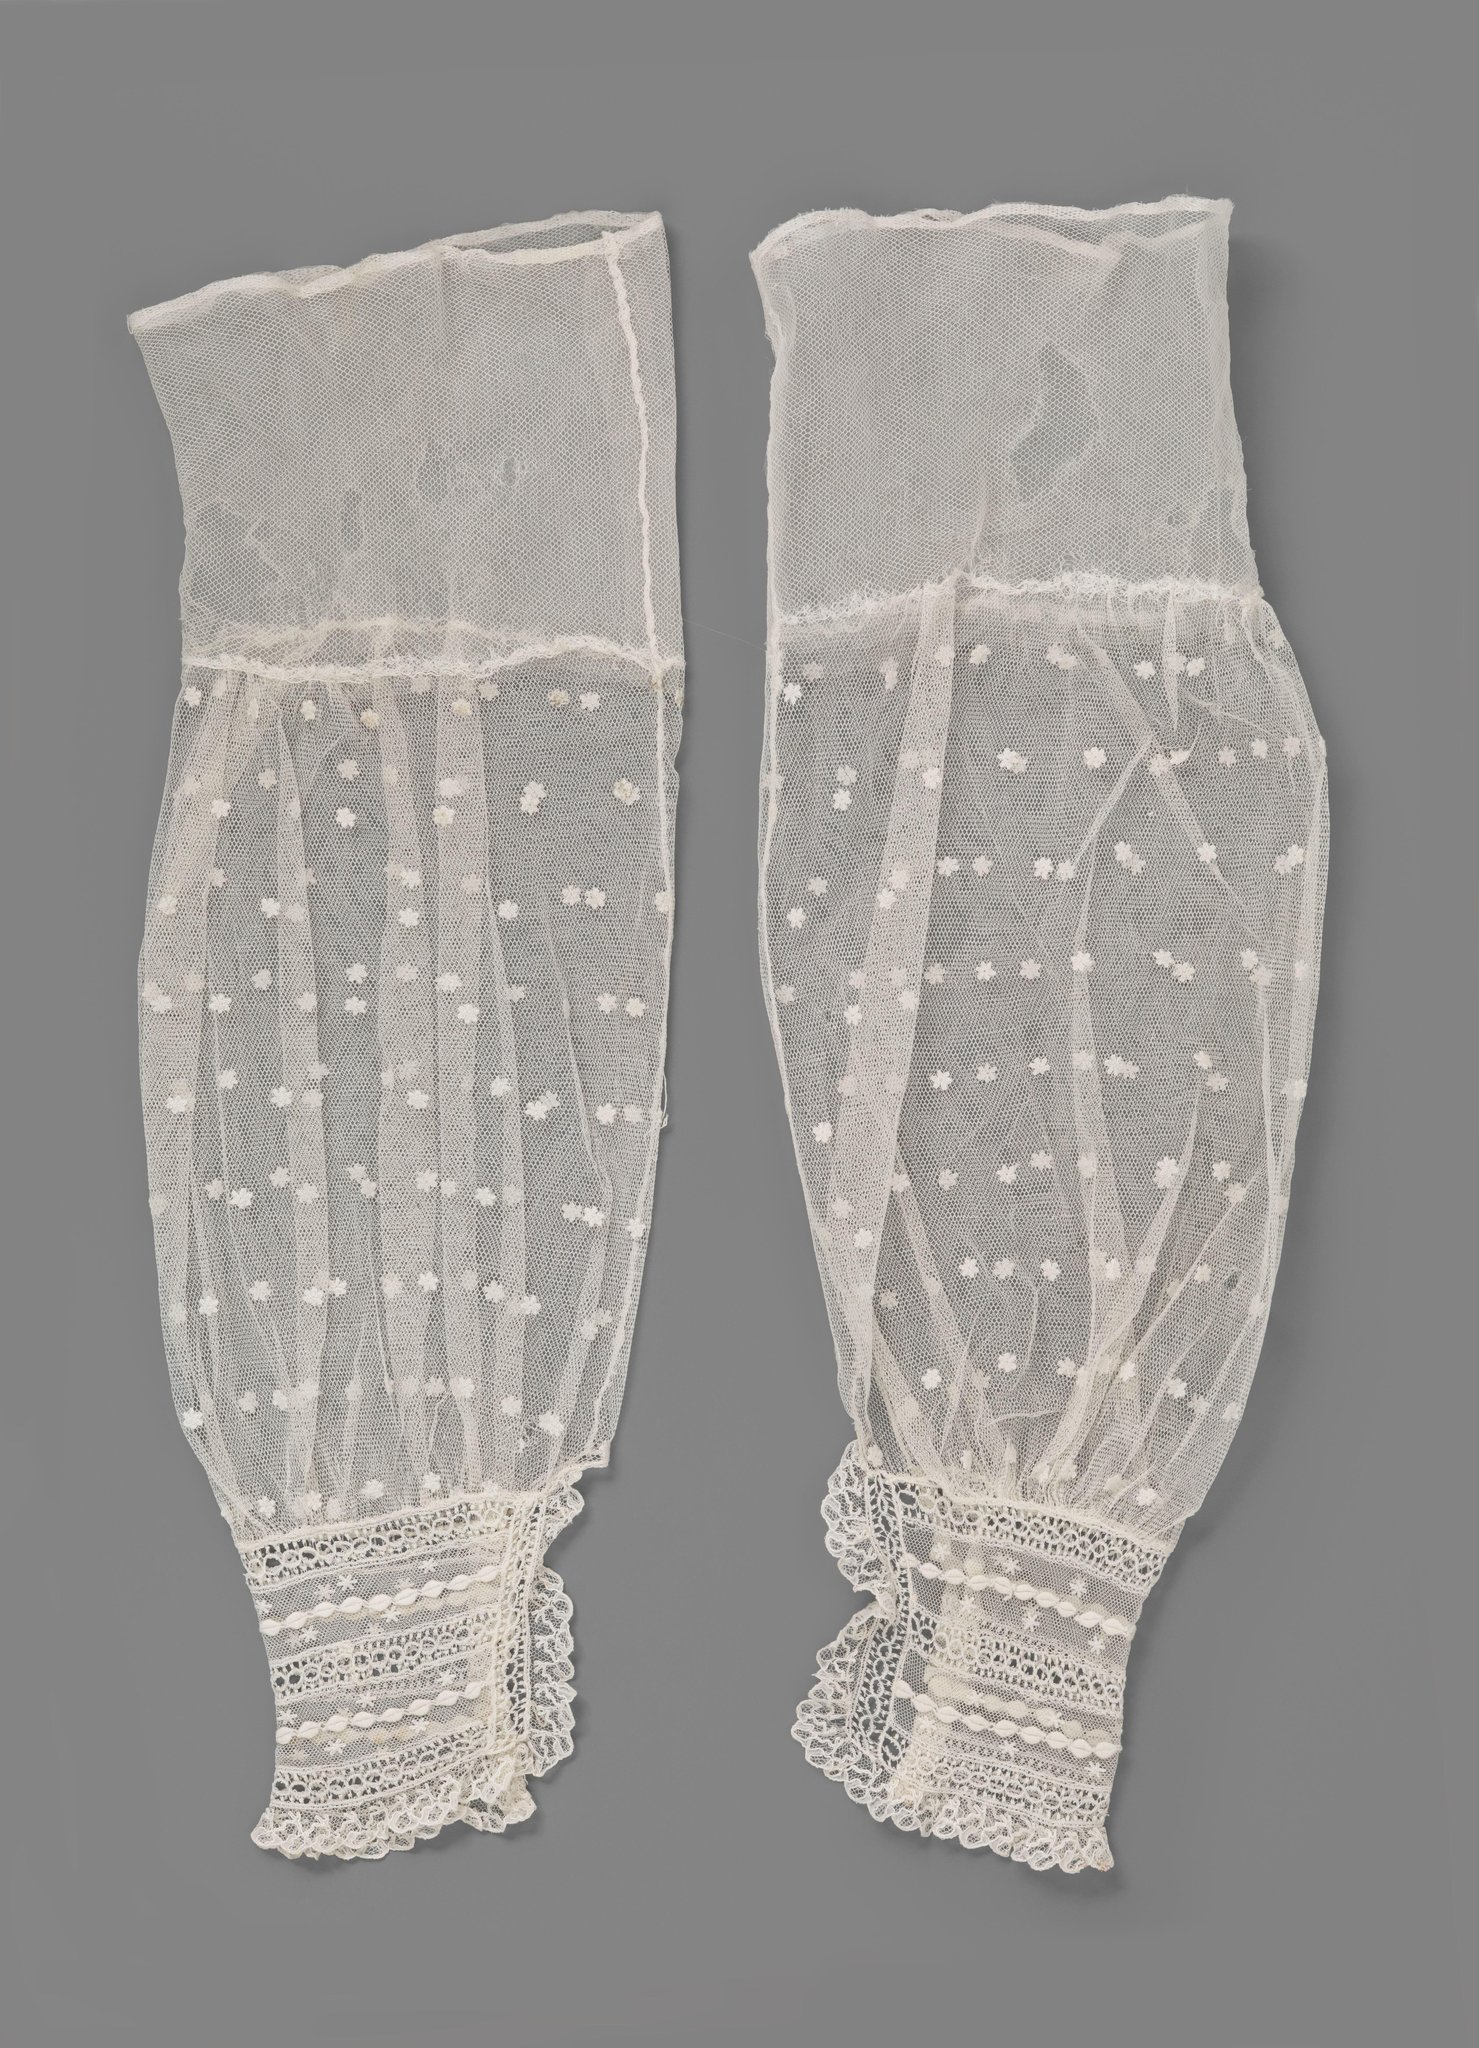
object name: voormouw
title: Voormouw met manchet van Rijsselse kant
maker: Anonymous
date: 1860-1880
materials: textile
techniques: embroidered, lace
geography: western europe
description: Voormouw met manchet van Rijsselse kant. Het ballonmodel heeft een lange gladde manchet met tussenzetsels en een strook Rijsselse kant. De mouw is geborduurd met bloemen en de manchet met sterren en bladeren. De drie kanten tussenzetsels bestaan elk uit een rij ronde gaten tussen strepen. De tule in de manchet is van een fijnere kwaliteit dan die van de mouw en is gedecoreerd met sterren en een aangenaaid lint in de vorm van koffiebonen. De boord van de manchet is geschulpt met een rij gebogen bloemtakken. De manchet heeft drie knoopsgaten, maar de knopen ontbreken.